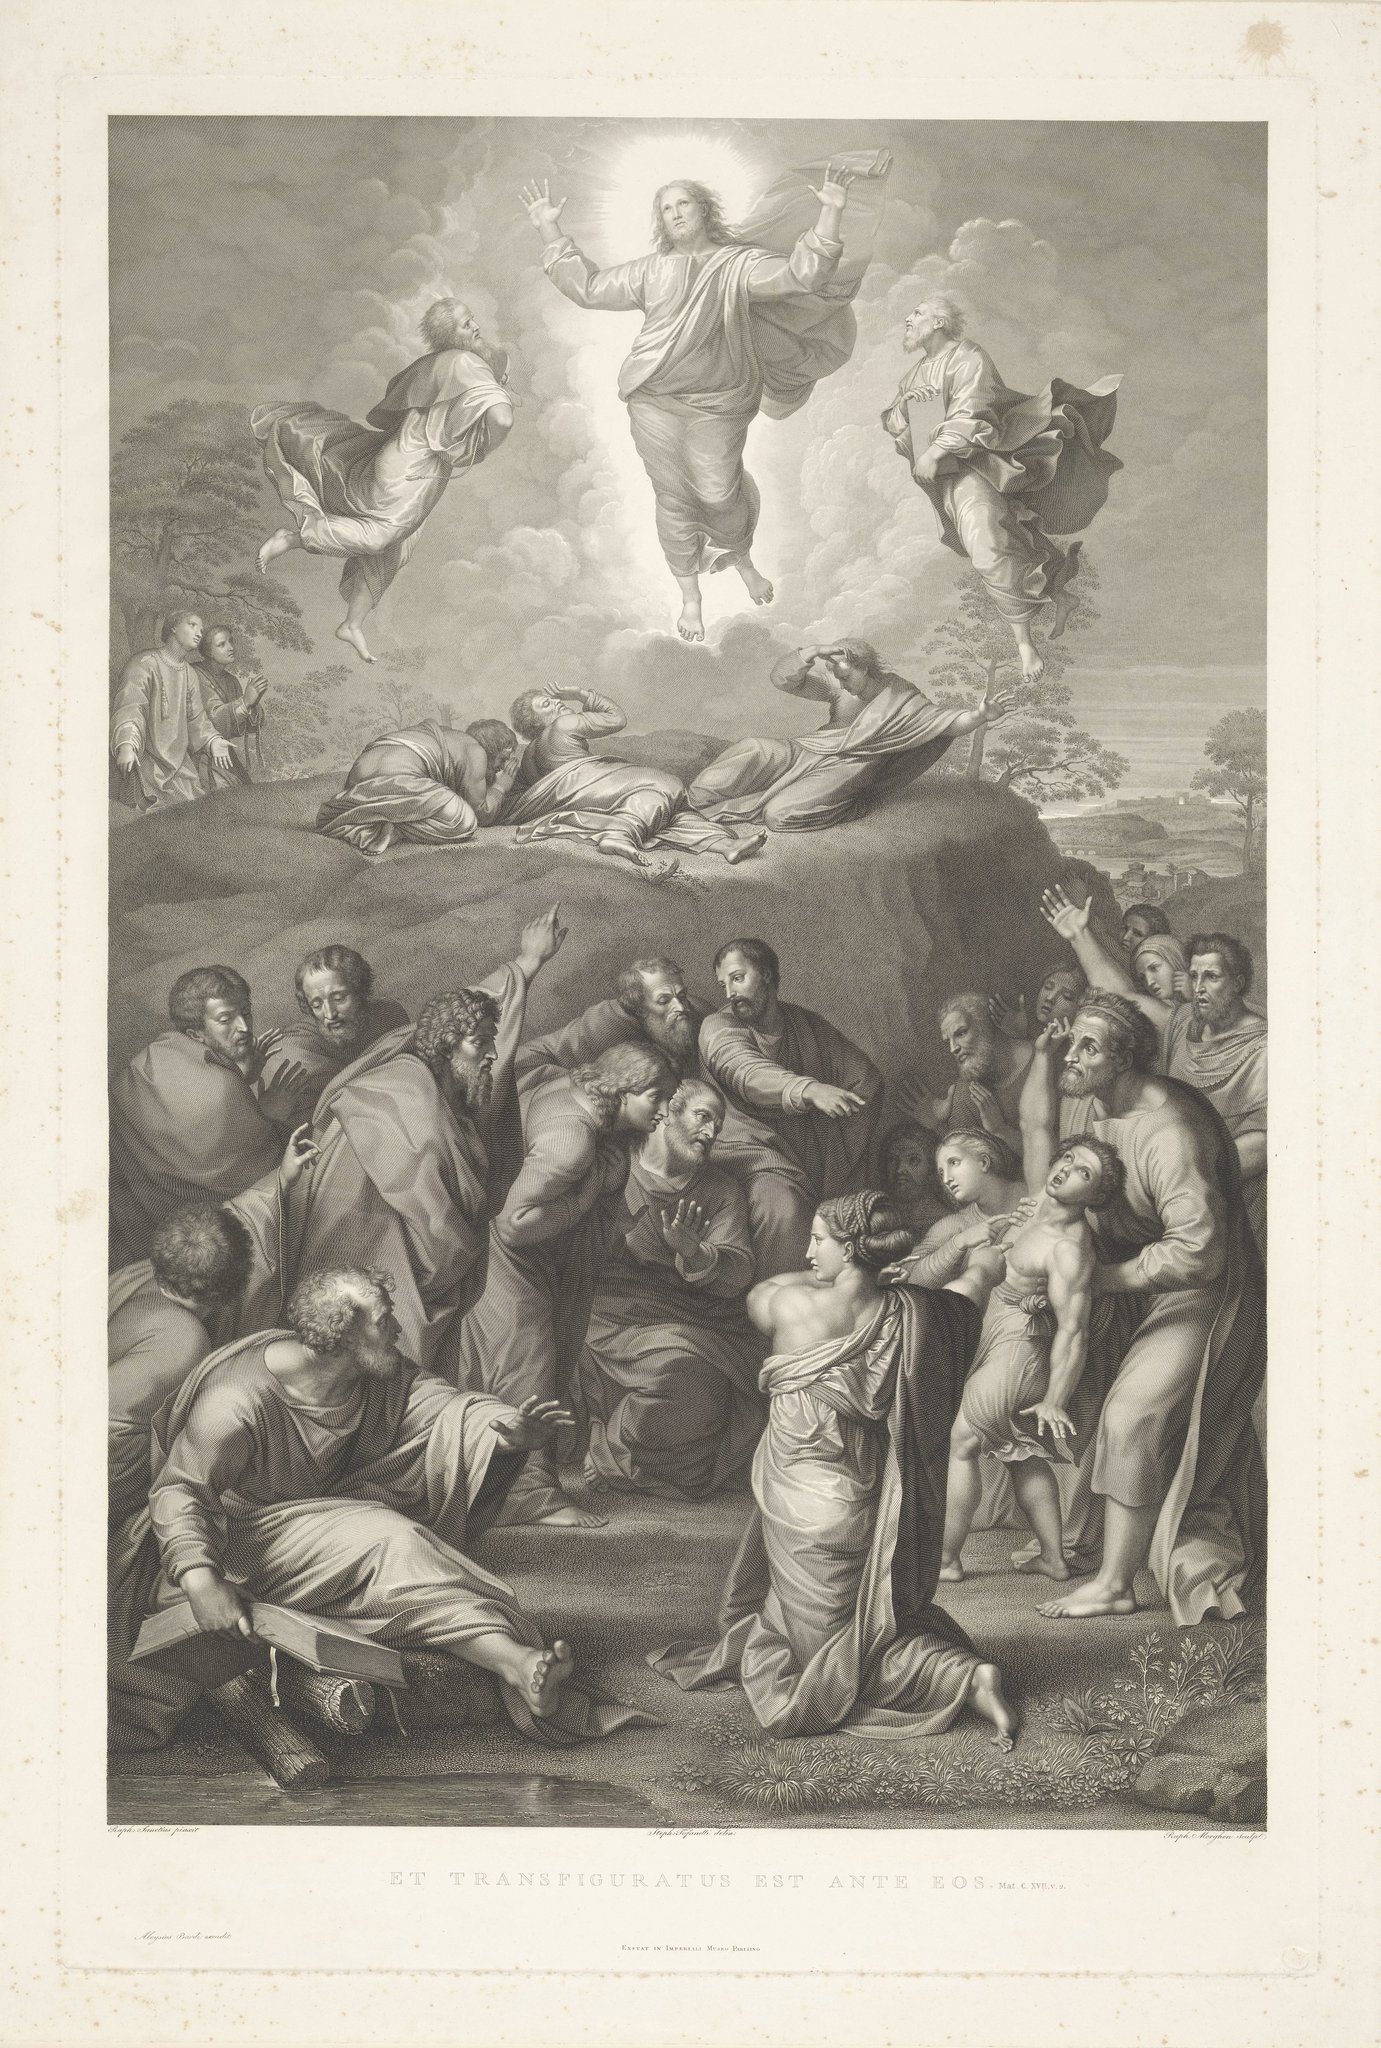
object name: print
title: Transfiguratie op de berg Tabor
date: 1768-1833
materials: paper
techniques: engraving, etching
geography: italy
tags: the transfiguration: moses and elijah appear on either side of christ on mount tabor (matthew 17:1-13; mark 9:2-13; luke 9:28-36)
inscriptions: collector's mark: Lugt 12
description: Christus zwevend in een stralenkrans van licht. Naast hem Elia en Mozes, als symbolen van de Oude Wet. De apostelen liggen op de top van de berg in het verblindende licht. Aan de voet van de berg een andere scène met de apostelen in gesprek met de schriftgeleerden. Een vader brengt zijn zieke zoon naar Christus om hem te laten genezen. Bijbelverwijzing in ondermarge.